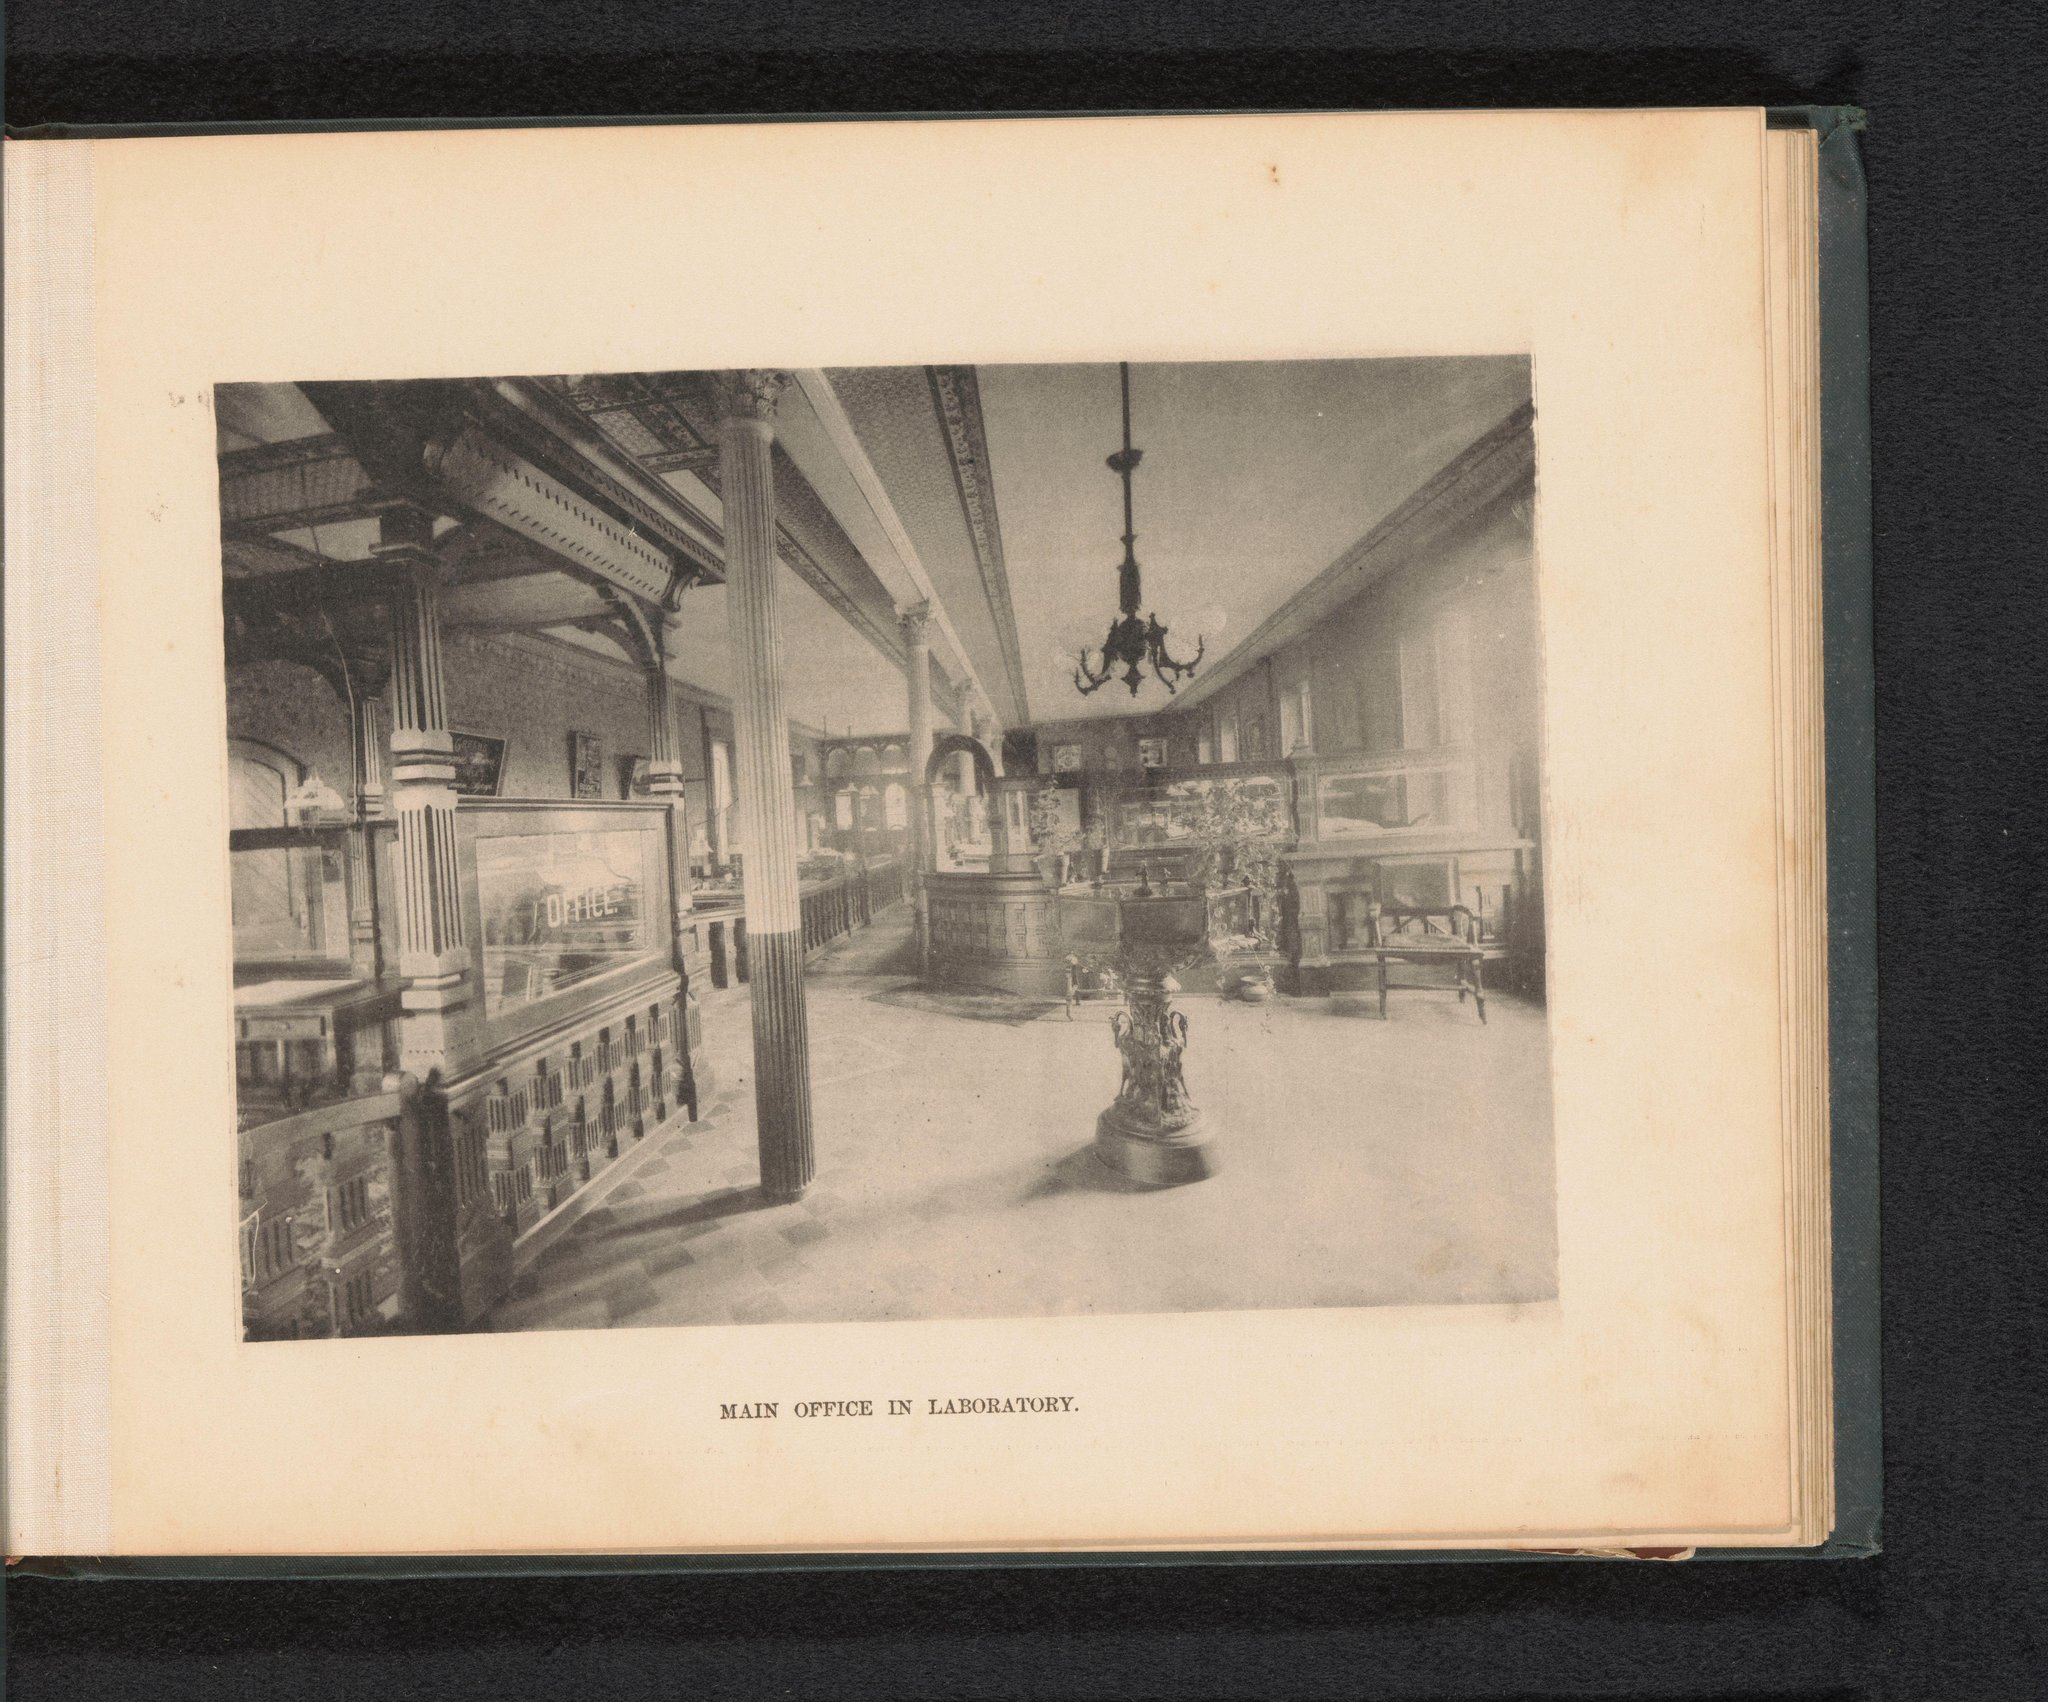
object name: page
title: Interieur van het laboratorium van George Gill Green voor Green's August Flower en Dr. Boschee's German Syrup in Woodbury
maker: Anonymous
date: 1879-1889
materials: paper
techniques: photograph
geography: woodbury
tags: laboratory, office (~ administration)